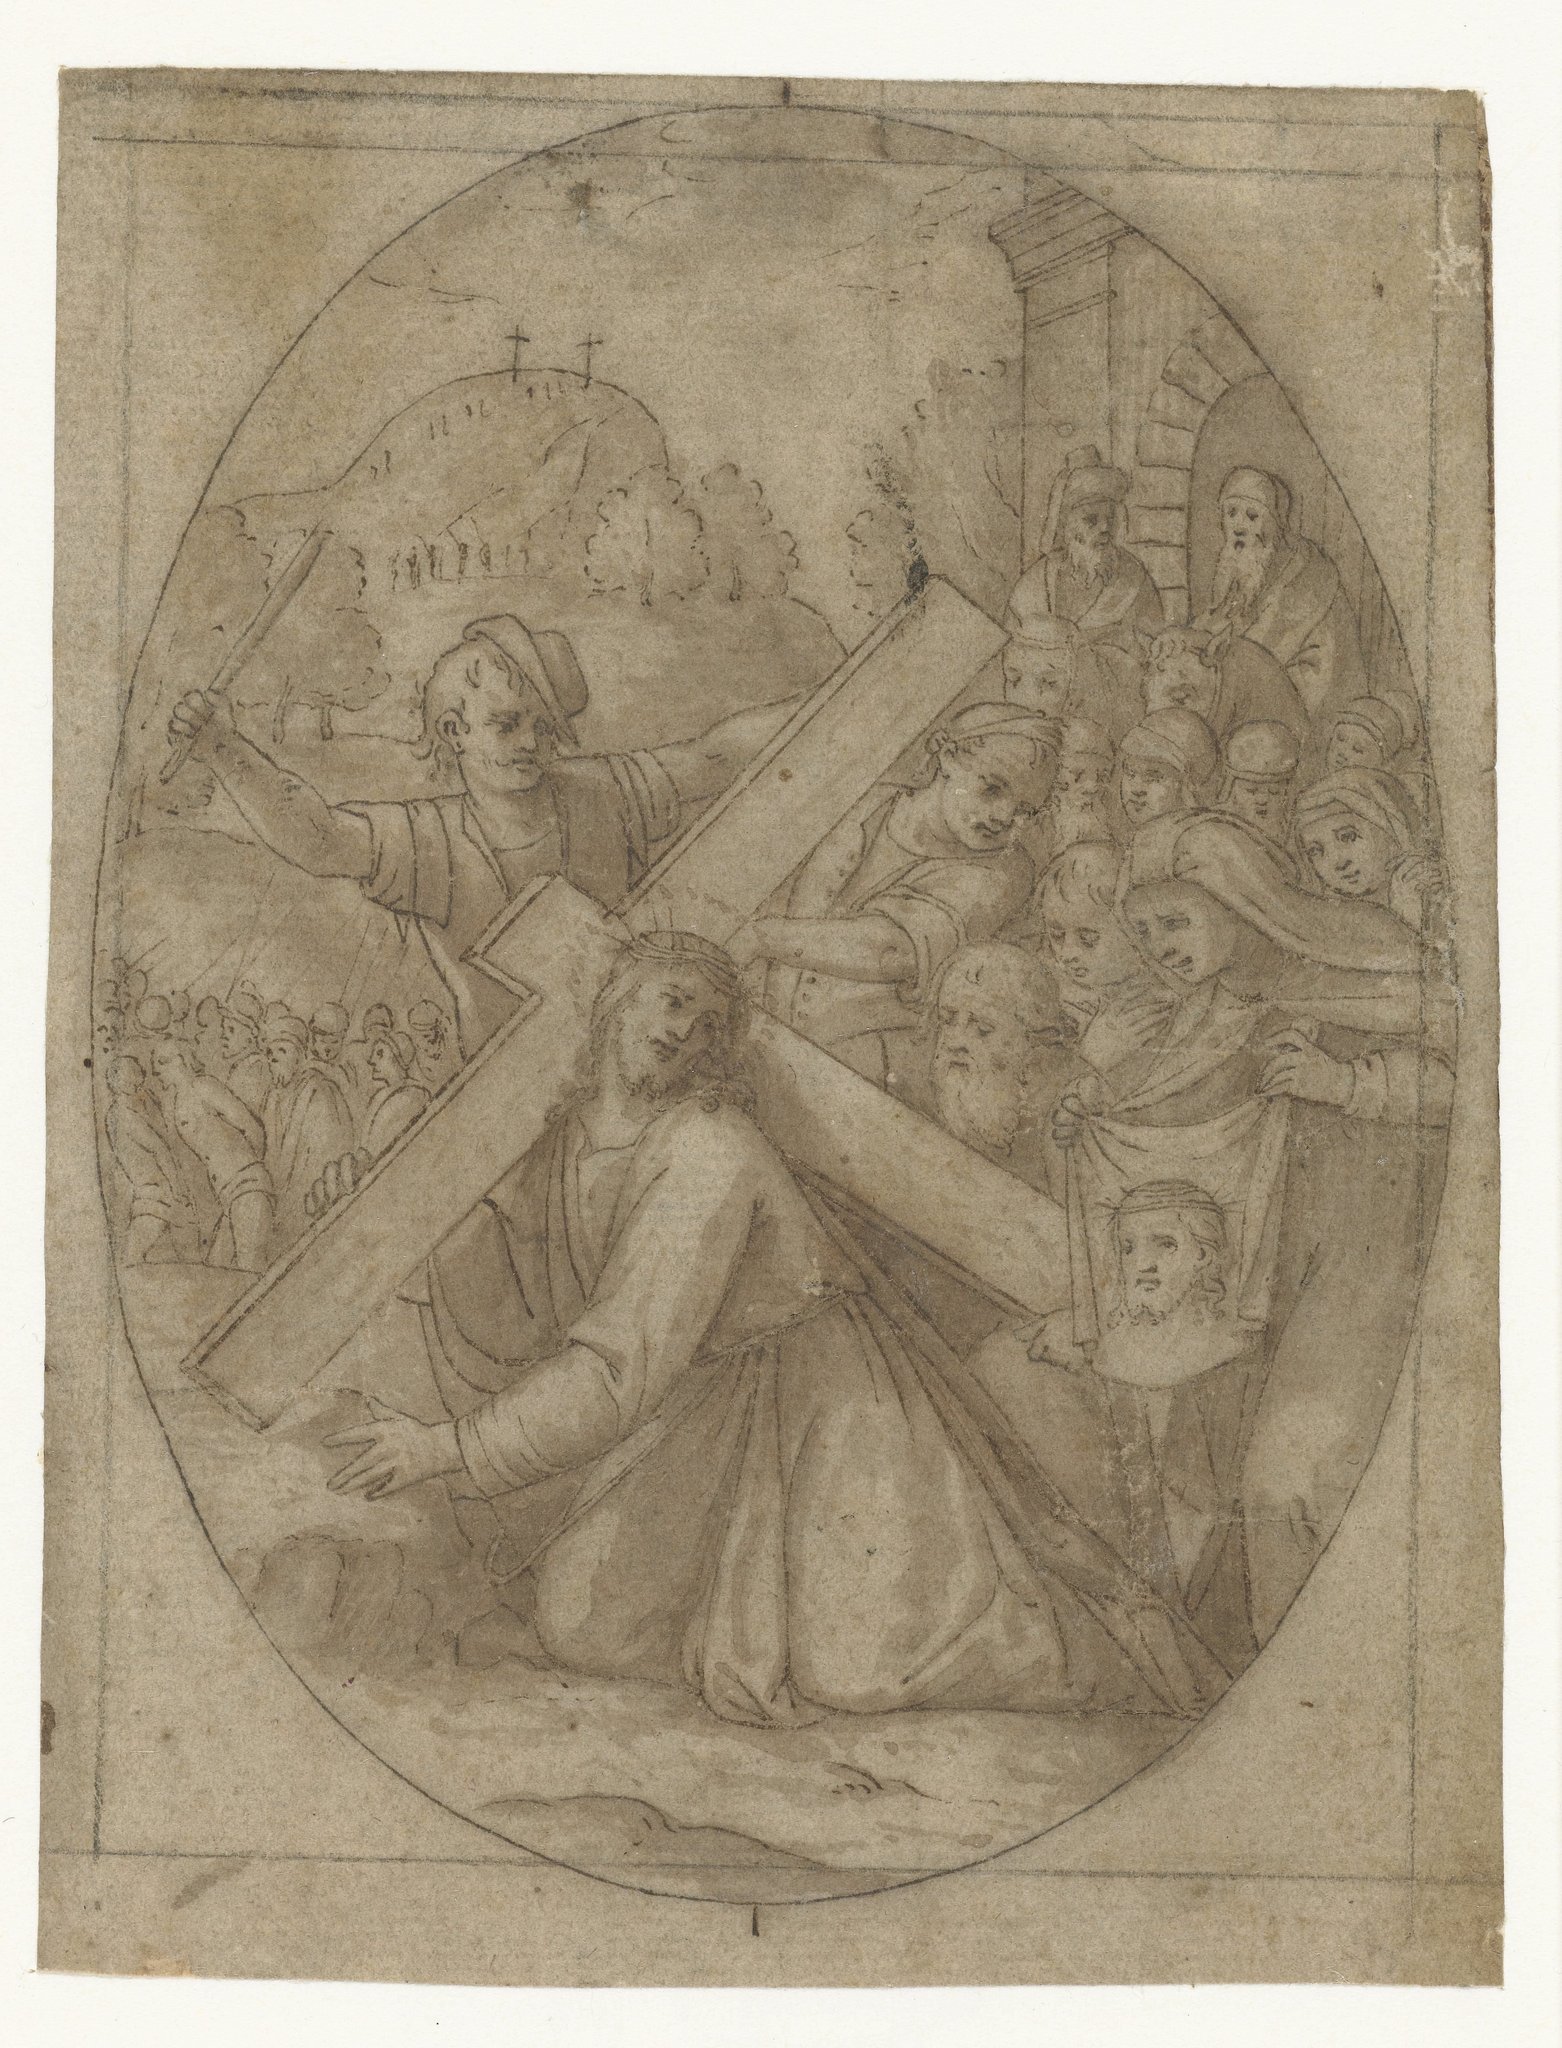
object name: drawing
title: Christus met het kruis en Veronica met doek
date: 1600-1650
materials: ink, paper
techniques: brush, pen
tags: veronica; possible attributes: 'sudarium' (veil with the image of christ), carrying of the cross: christ bearing the cross, alone or with the help of others (e.g. simon the cyrenian)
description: Christus draagt het kruis en Veronica met de doek. In ovaal. Doorgetrokken voor een prent.